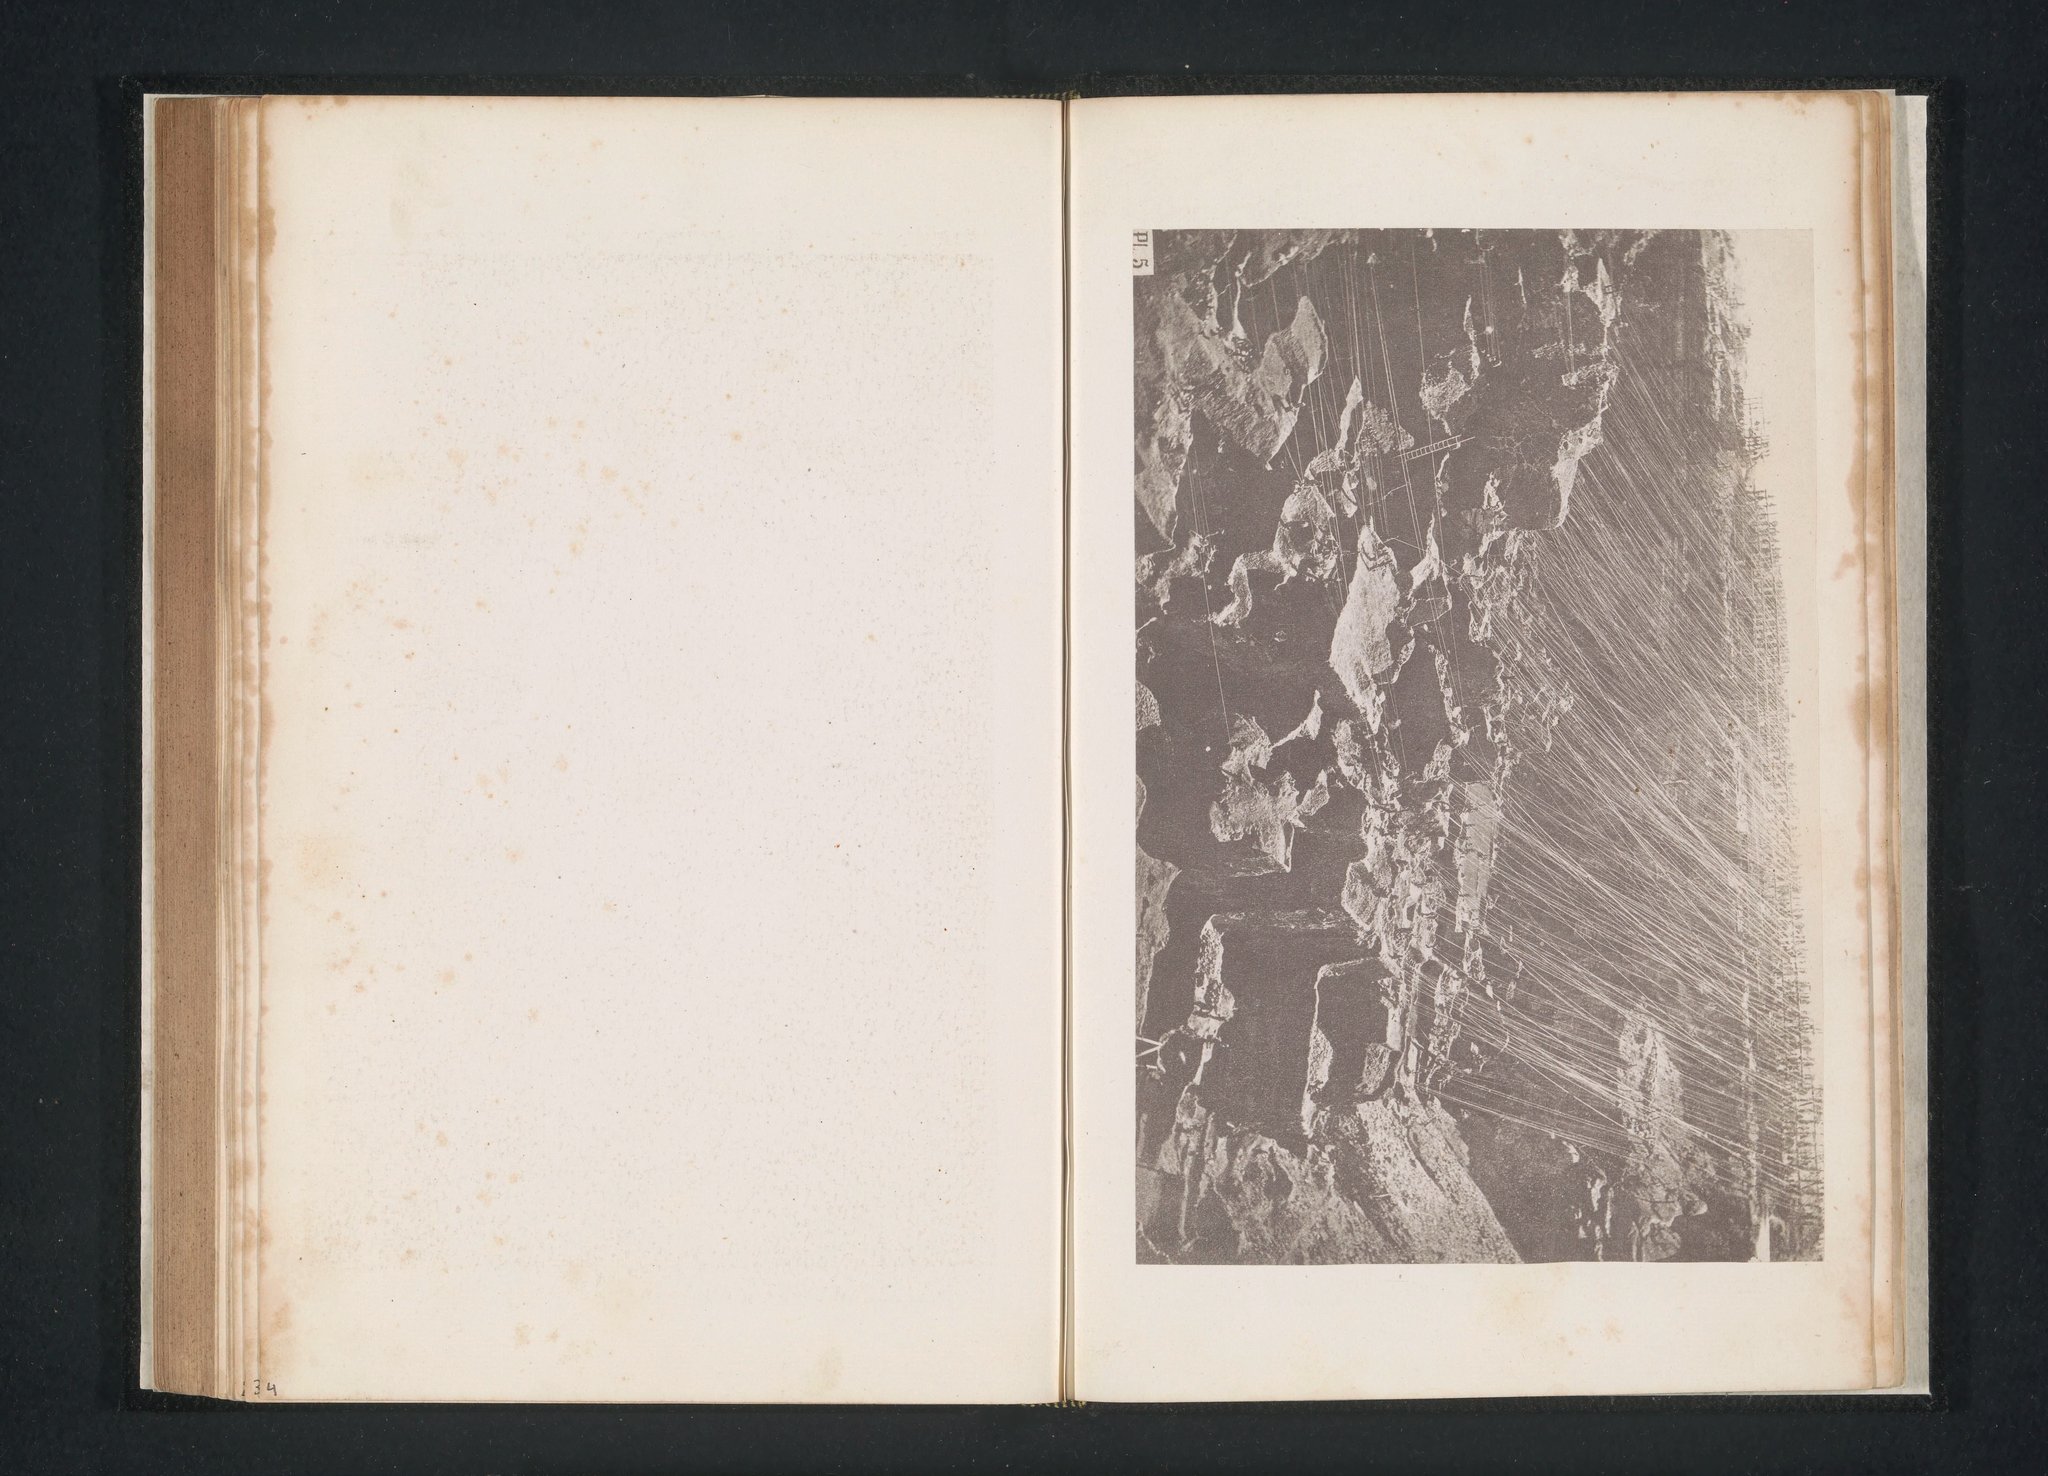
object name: page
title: Gezicht op de diamantmijn bij Kimberley in Zuid-Afrika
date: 1870-1880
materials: paper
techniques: photograph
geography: kimberley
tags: mine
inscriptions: number: ‘Pl. 5’